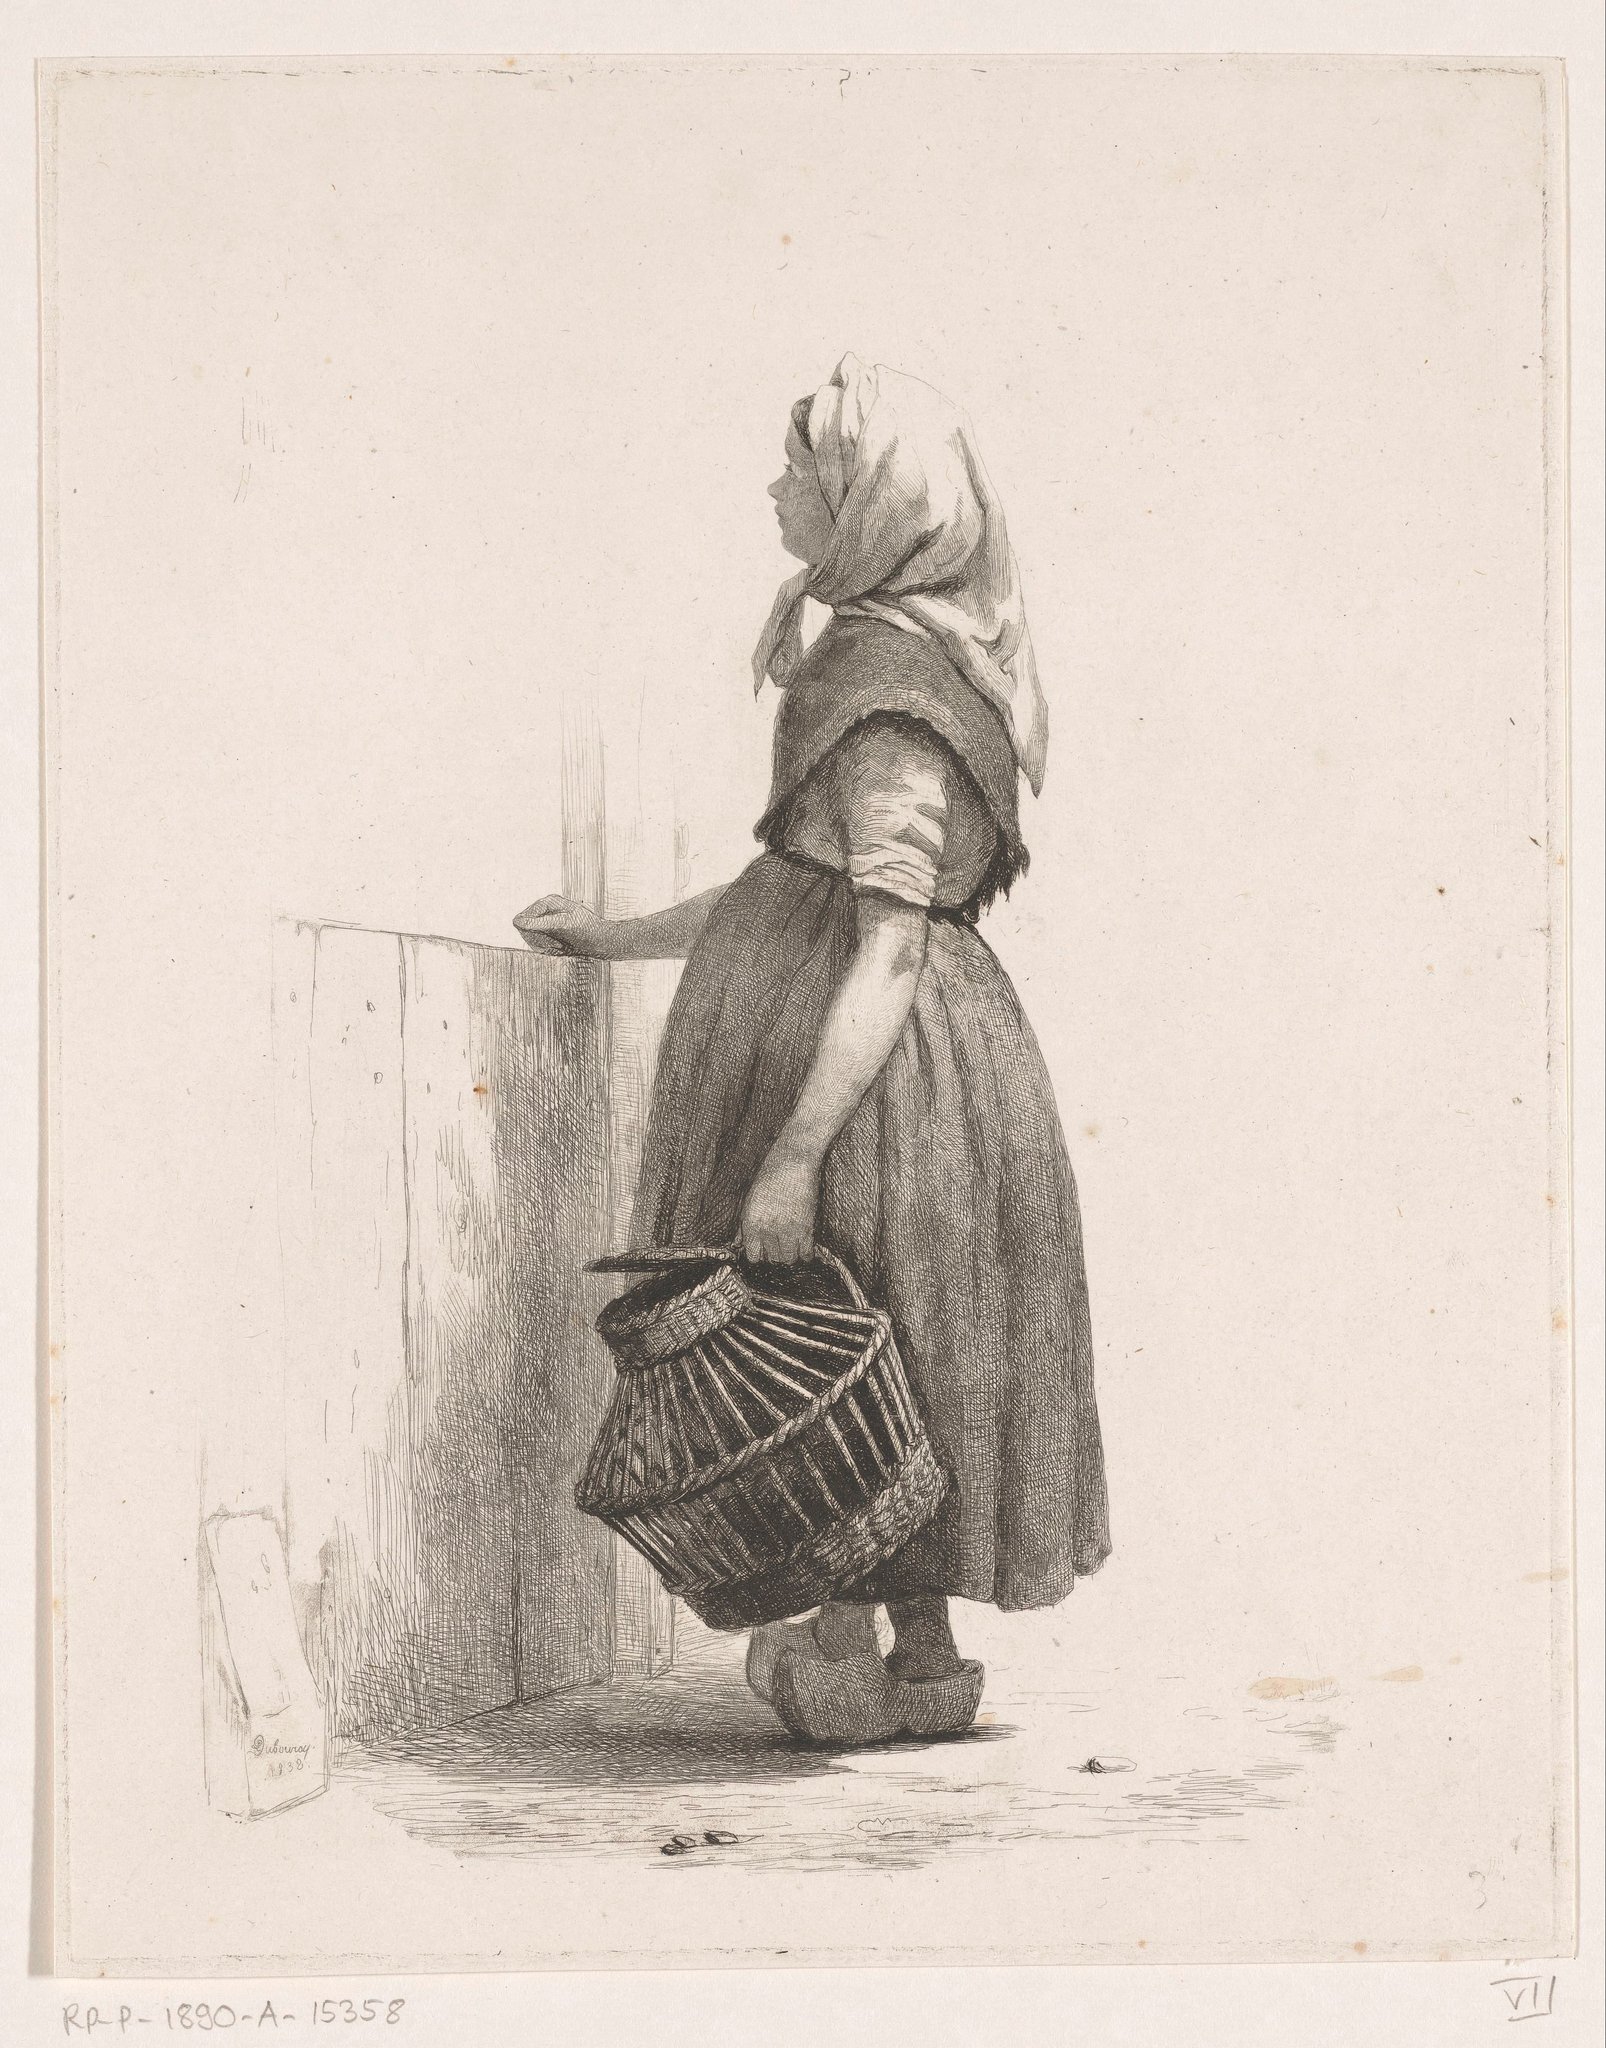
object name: print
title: Vijf etsproeven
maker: pierre louis dubourcq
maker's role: draughtsman, painter, print maker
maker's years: 1815-1873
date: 1838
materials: paper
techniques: drypoint, etching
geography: netherlands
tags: fowl (cock, hen, chicken, etc.) (+ animal cage)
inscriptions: collector's mark: Lugt 2228